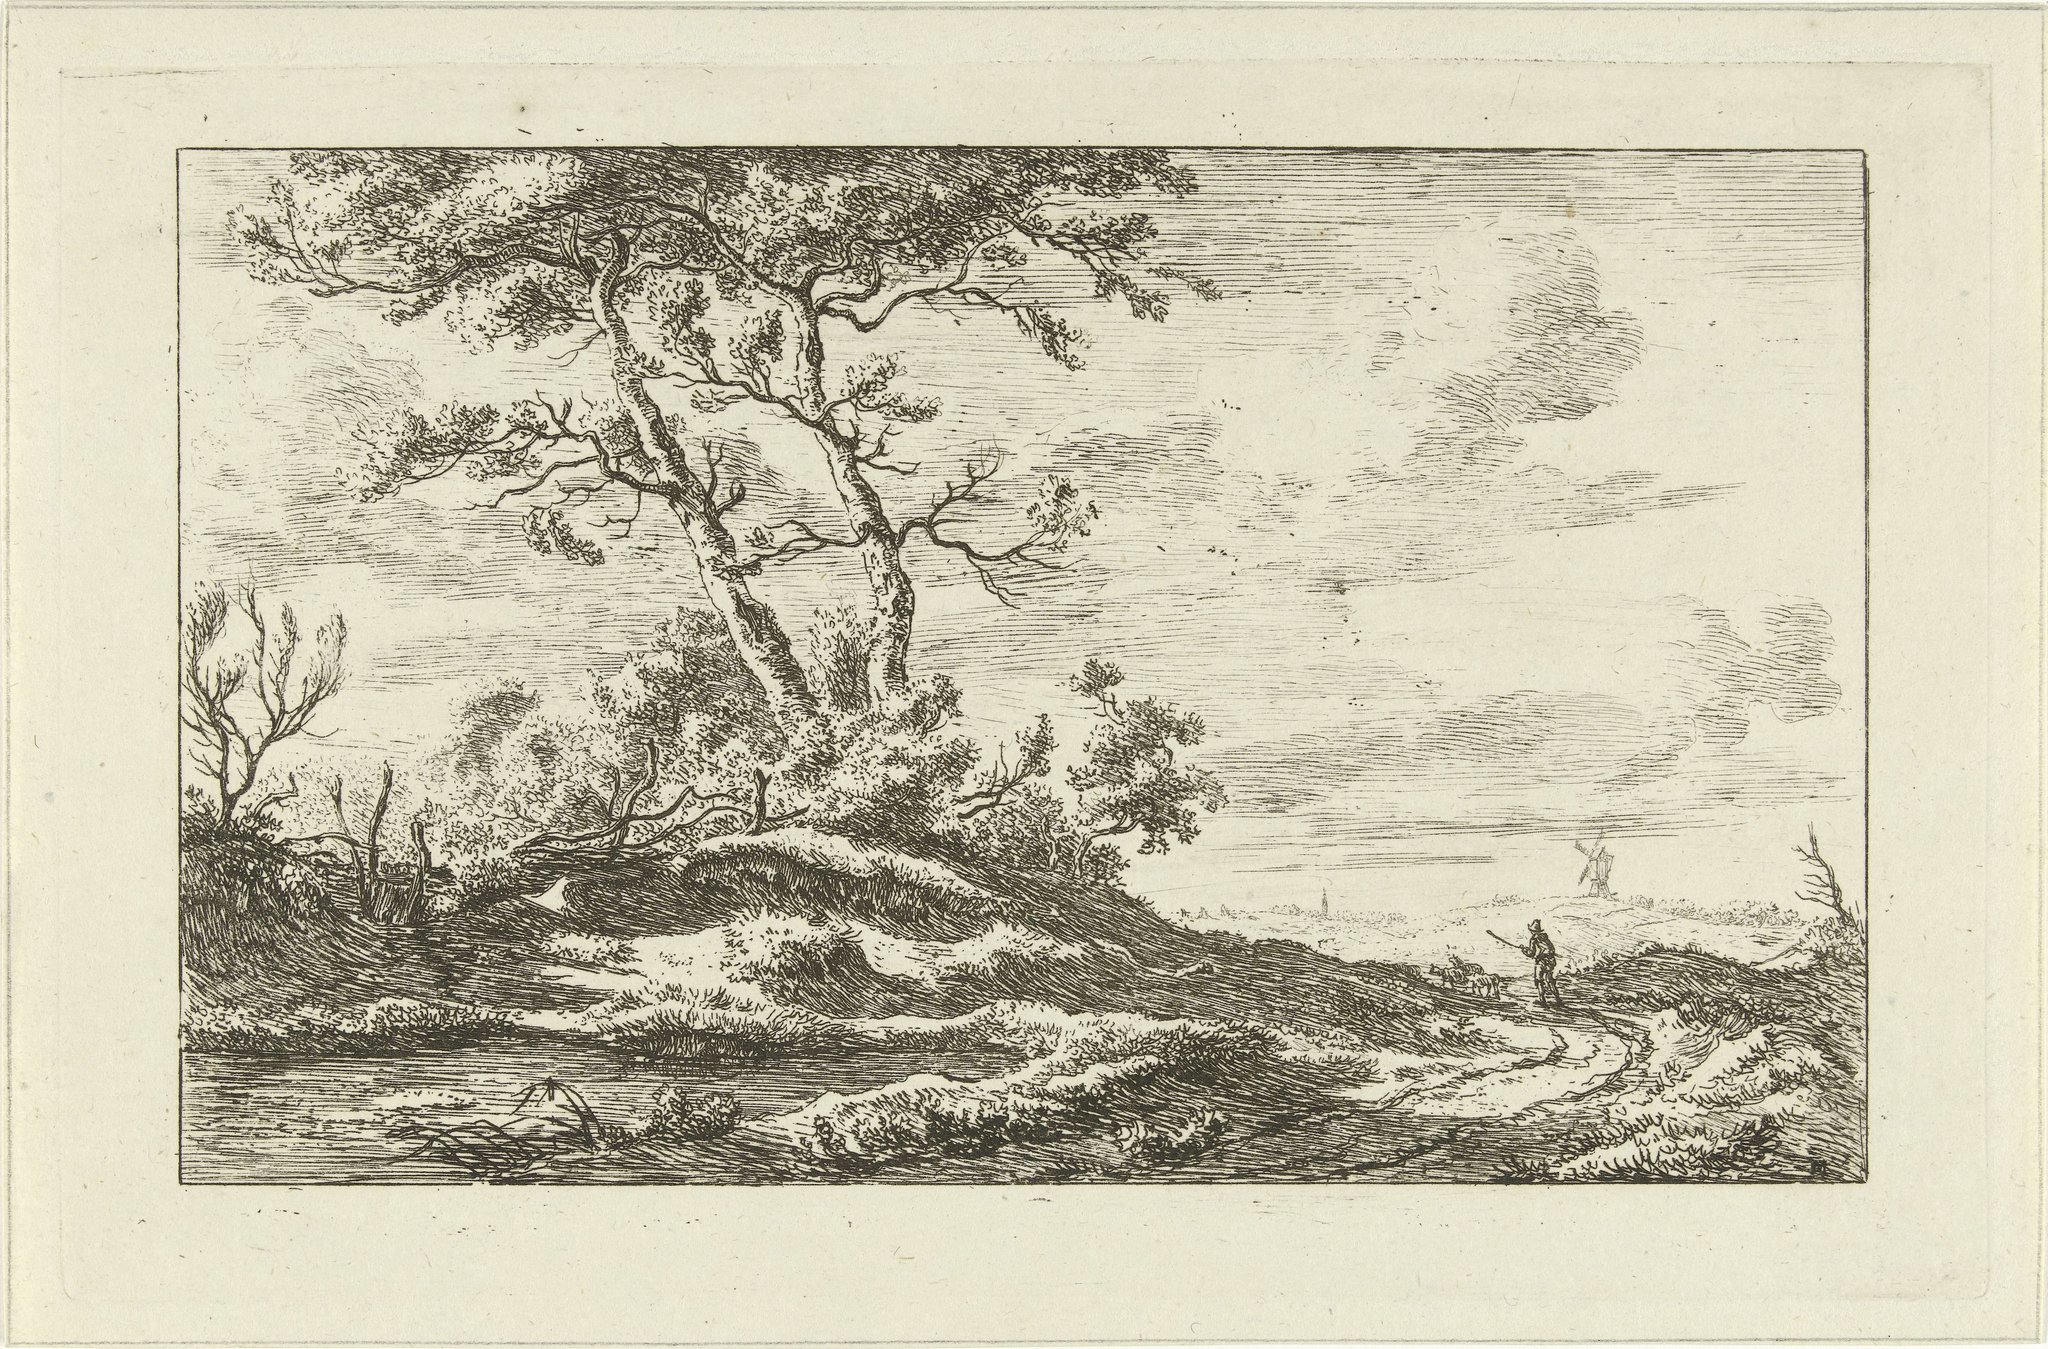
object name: print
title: Herder op een landweg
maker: carel lodewijk hansen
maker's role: draughtsman, painter, print maker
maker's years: 1765-1840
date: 1780-1840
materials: paper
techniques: etching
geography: netherlands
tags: herding, herdsman, herdswoman, shepherd, shepherdess, cowherd, etc., landscapes (+ landscape with figures, staffage)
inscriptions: collector's mark: Lugt 2228